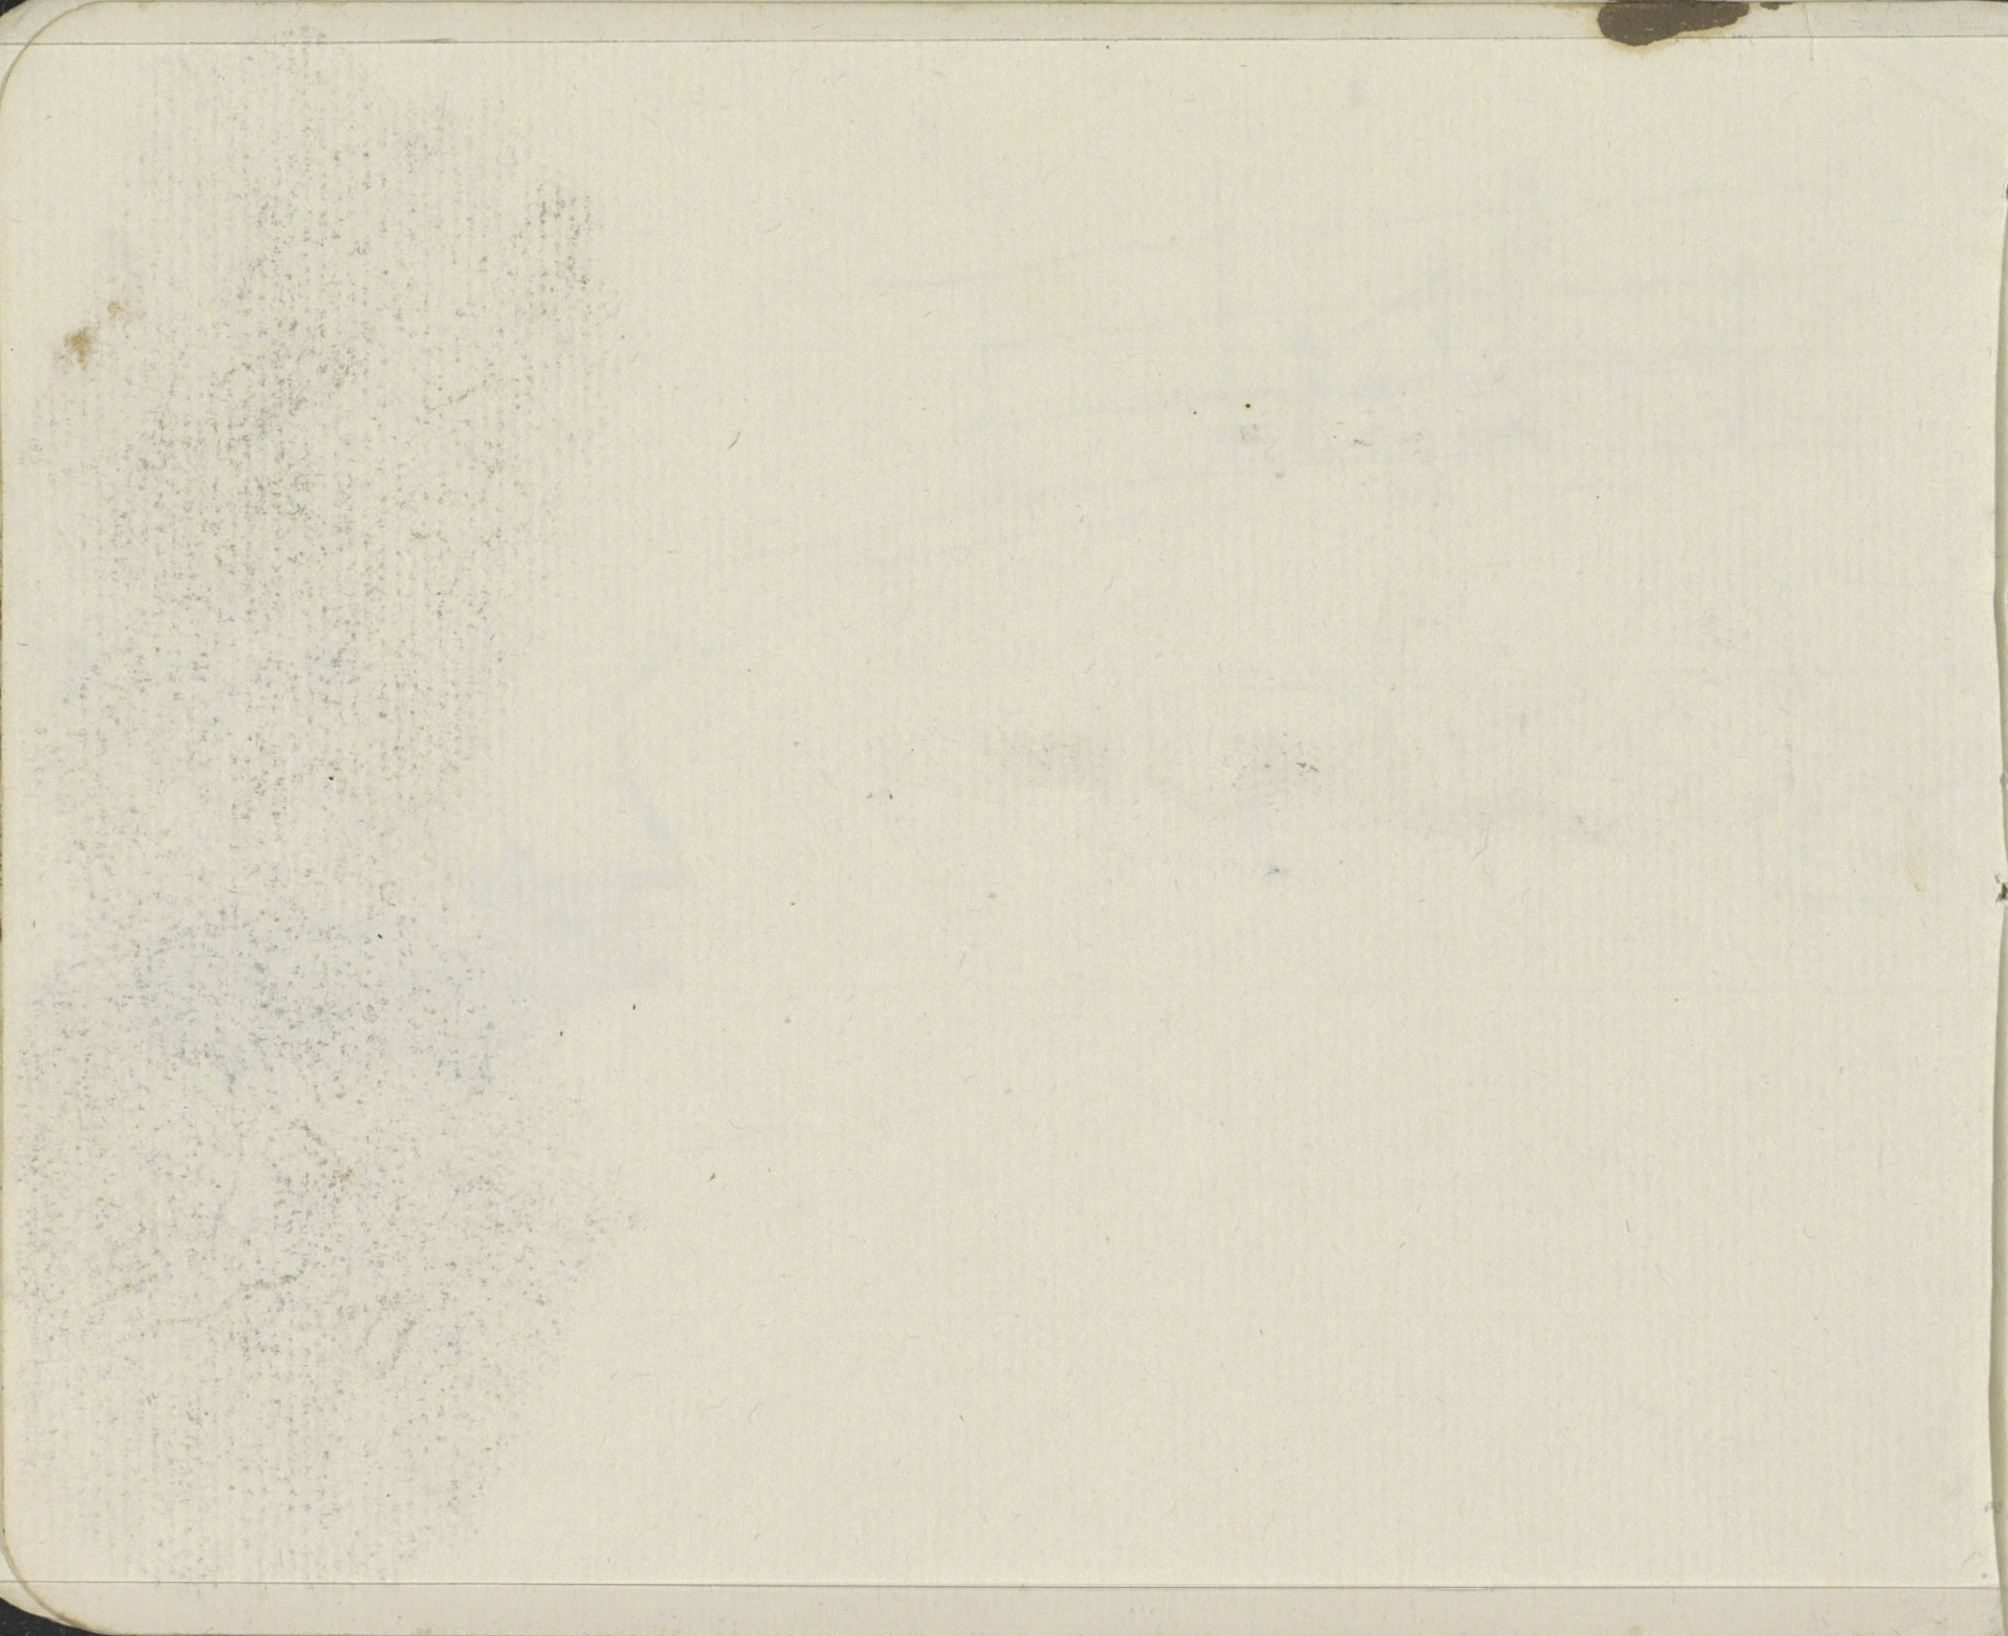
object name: sketchbook leaf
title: Abklatsch van de tekening op blad 4 recto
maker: willem witsen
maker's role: draughtsman, painter, print maker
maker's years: 1860-1923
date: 1915-1921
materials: paper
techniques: printmaking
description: Blad 3 verso uit een schetsboek met 23 bladen.